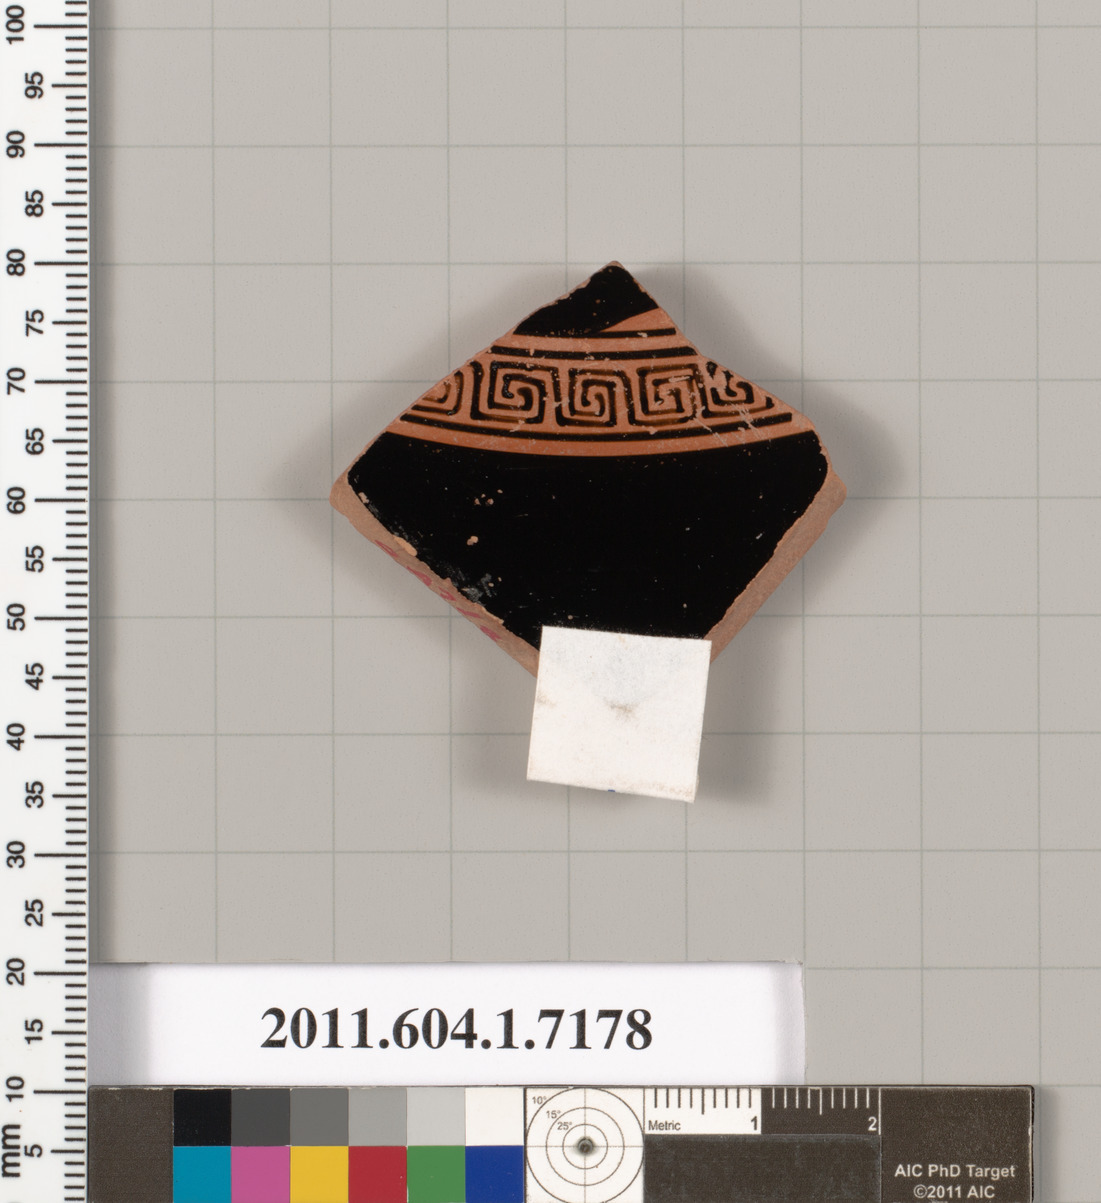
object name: kylix fragment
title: Terracotta fragment of a kylix (drinking cup)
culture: greek, attic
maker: makron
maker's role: artist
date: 500-480 BCE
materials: terracotta